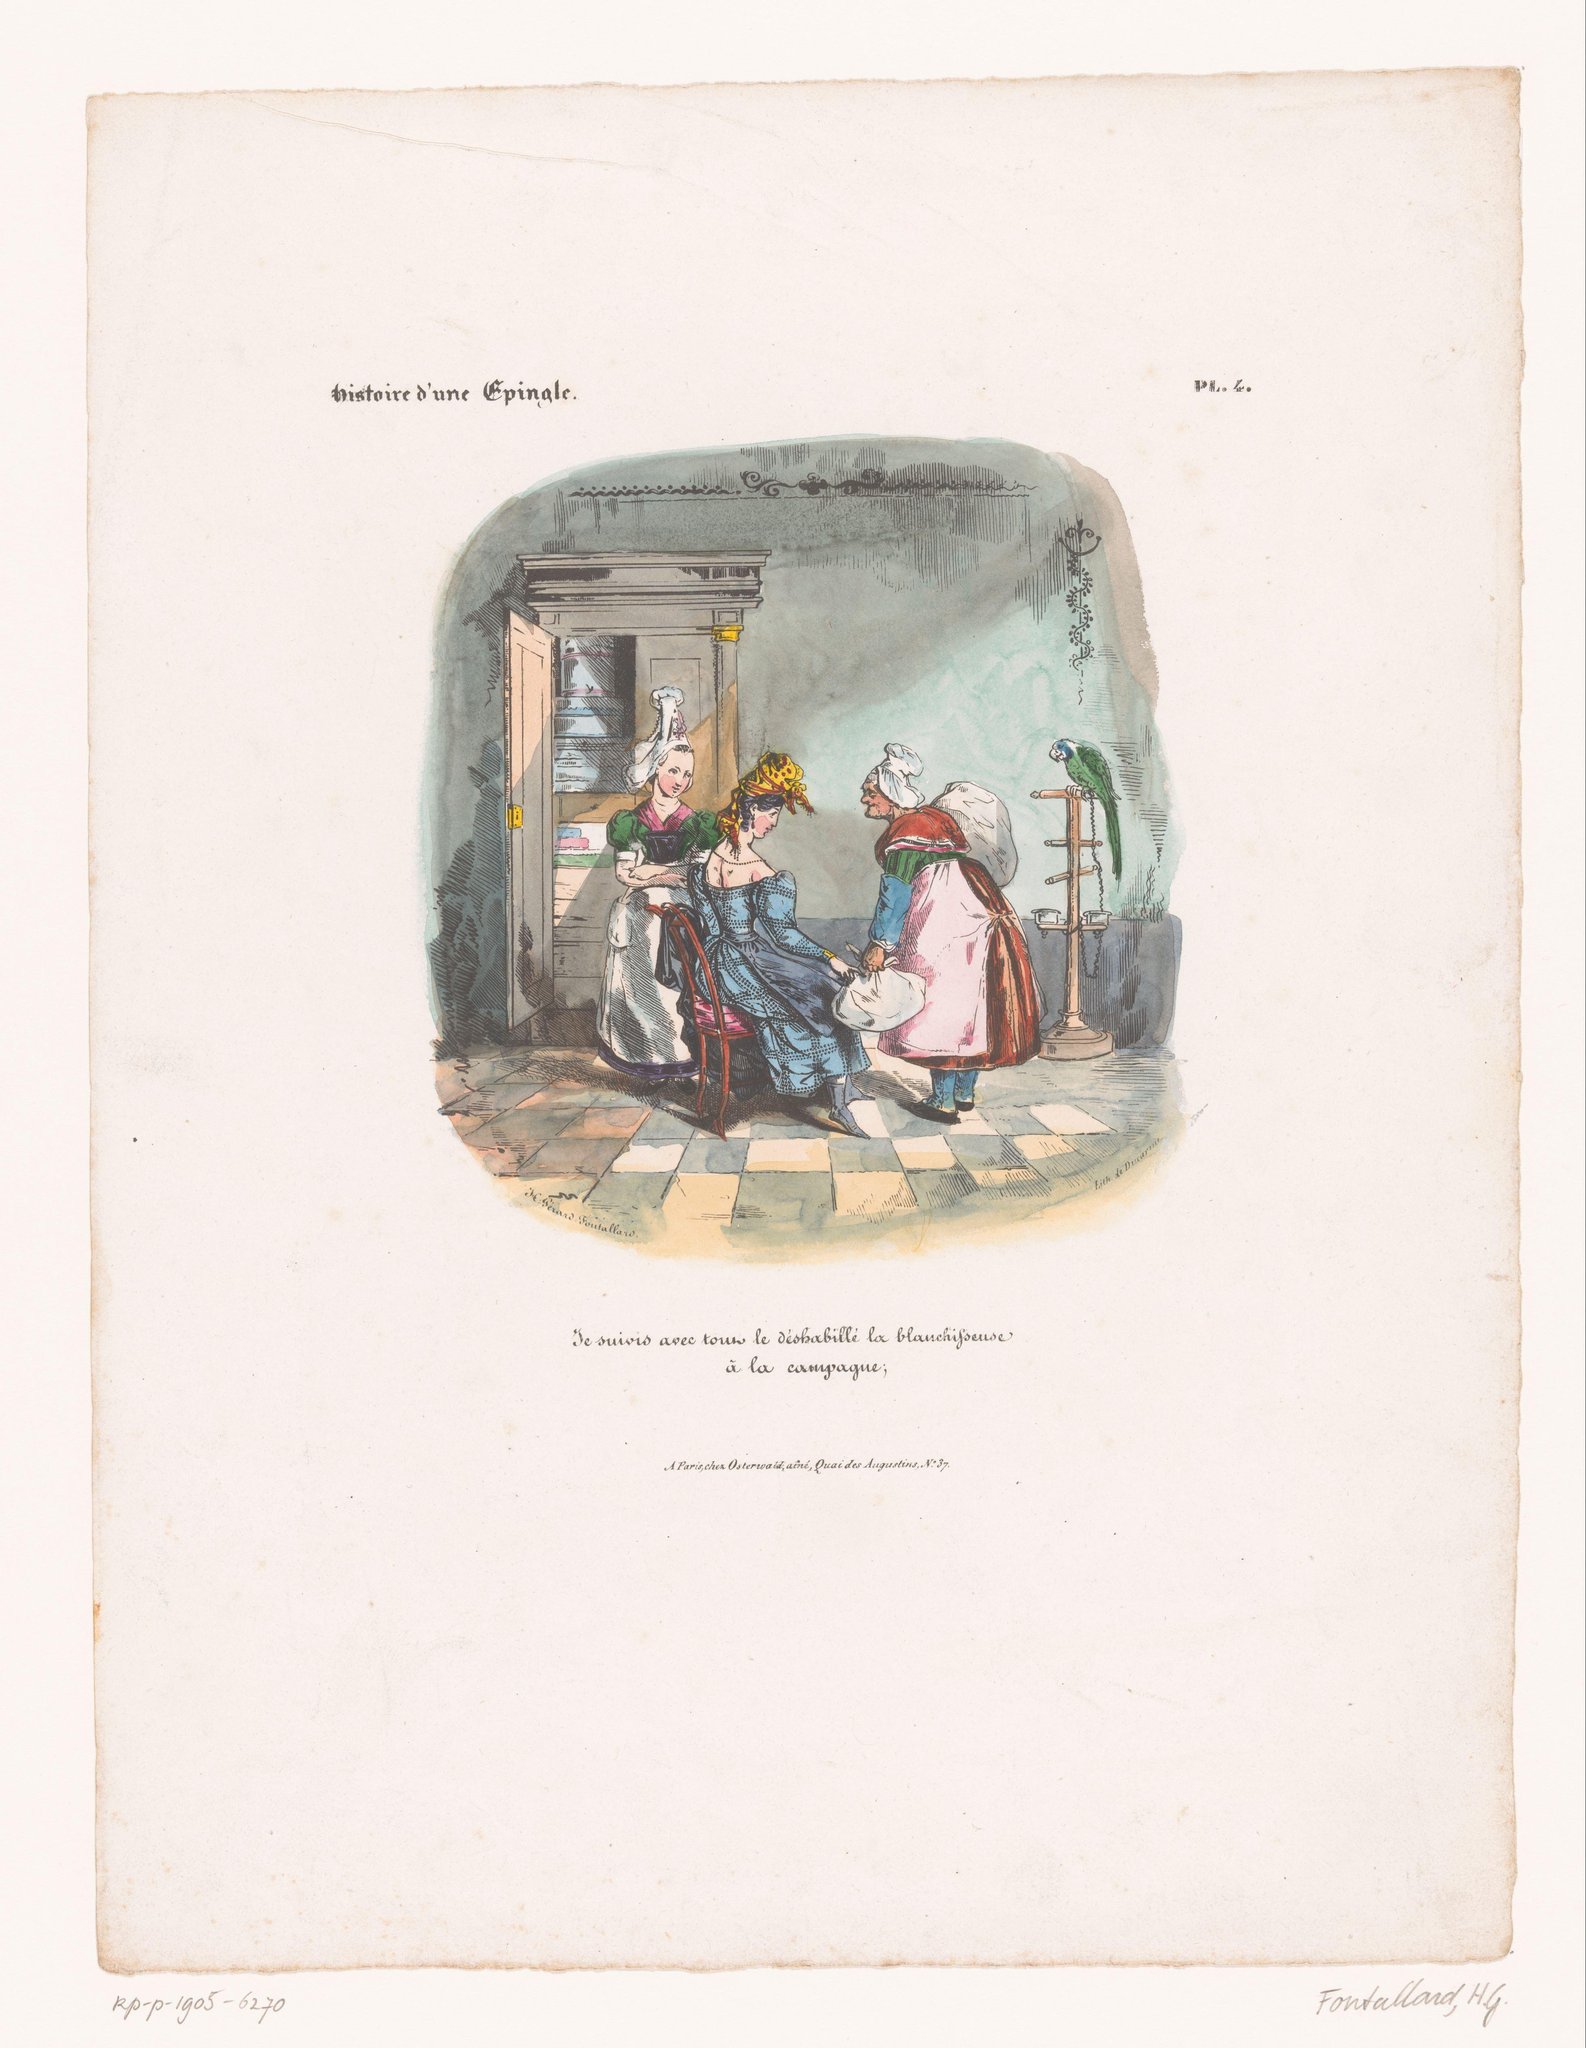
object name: print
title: Modeaccessoires met een verhaal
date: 1828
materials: paper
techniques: hand coloring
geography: paris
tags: laundering, maid ~ house personnel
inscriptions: collector's mark: Lugt 2228a